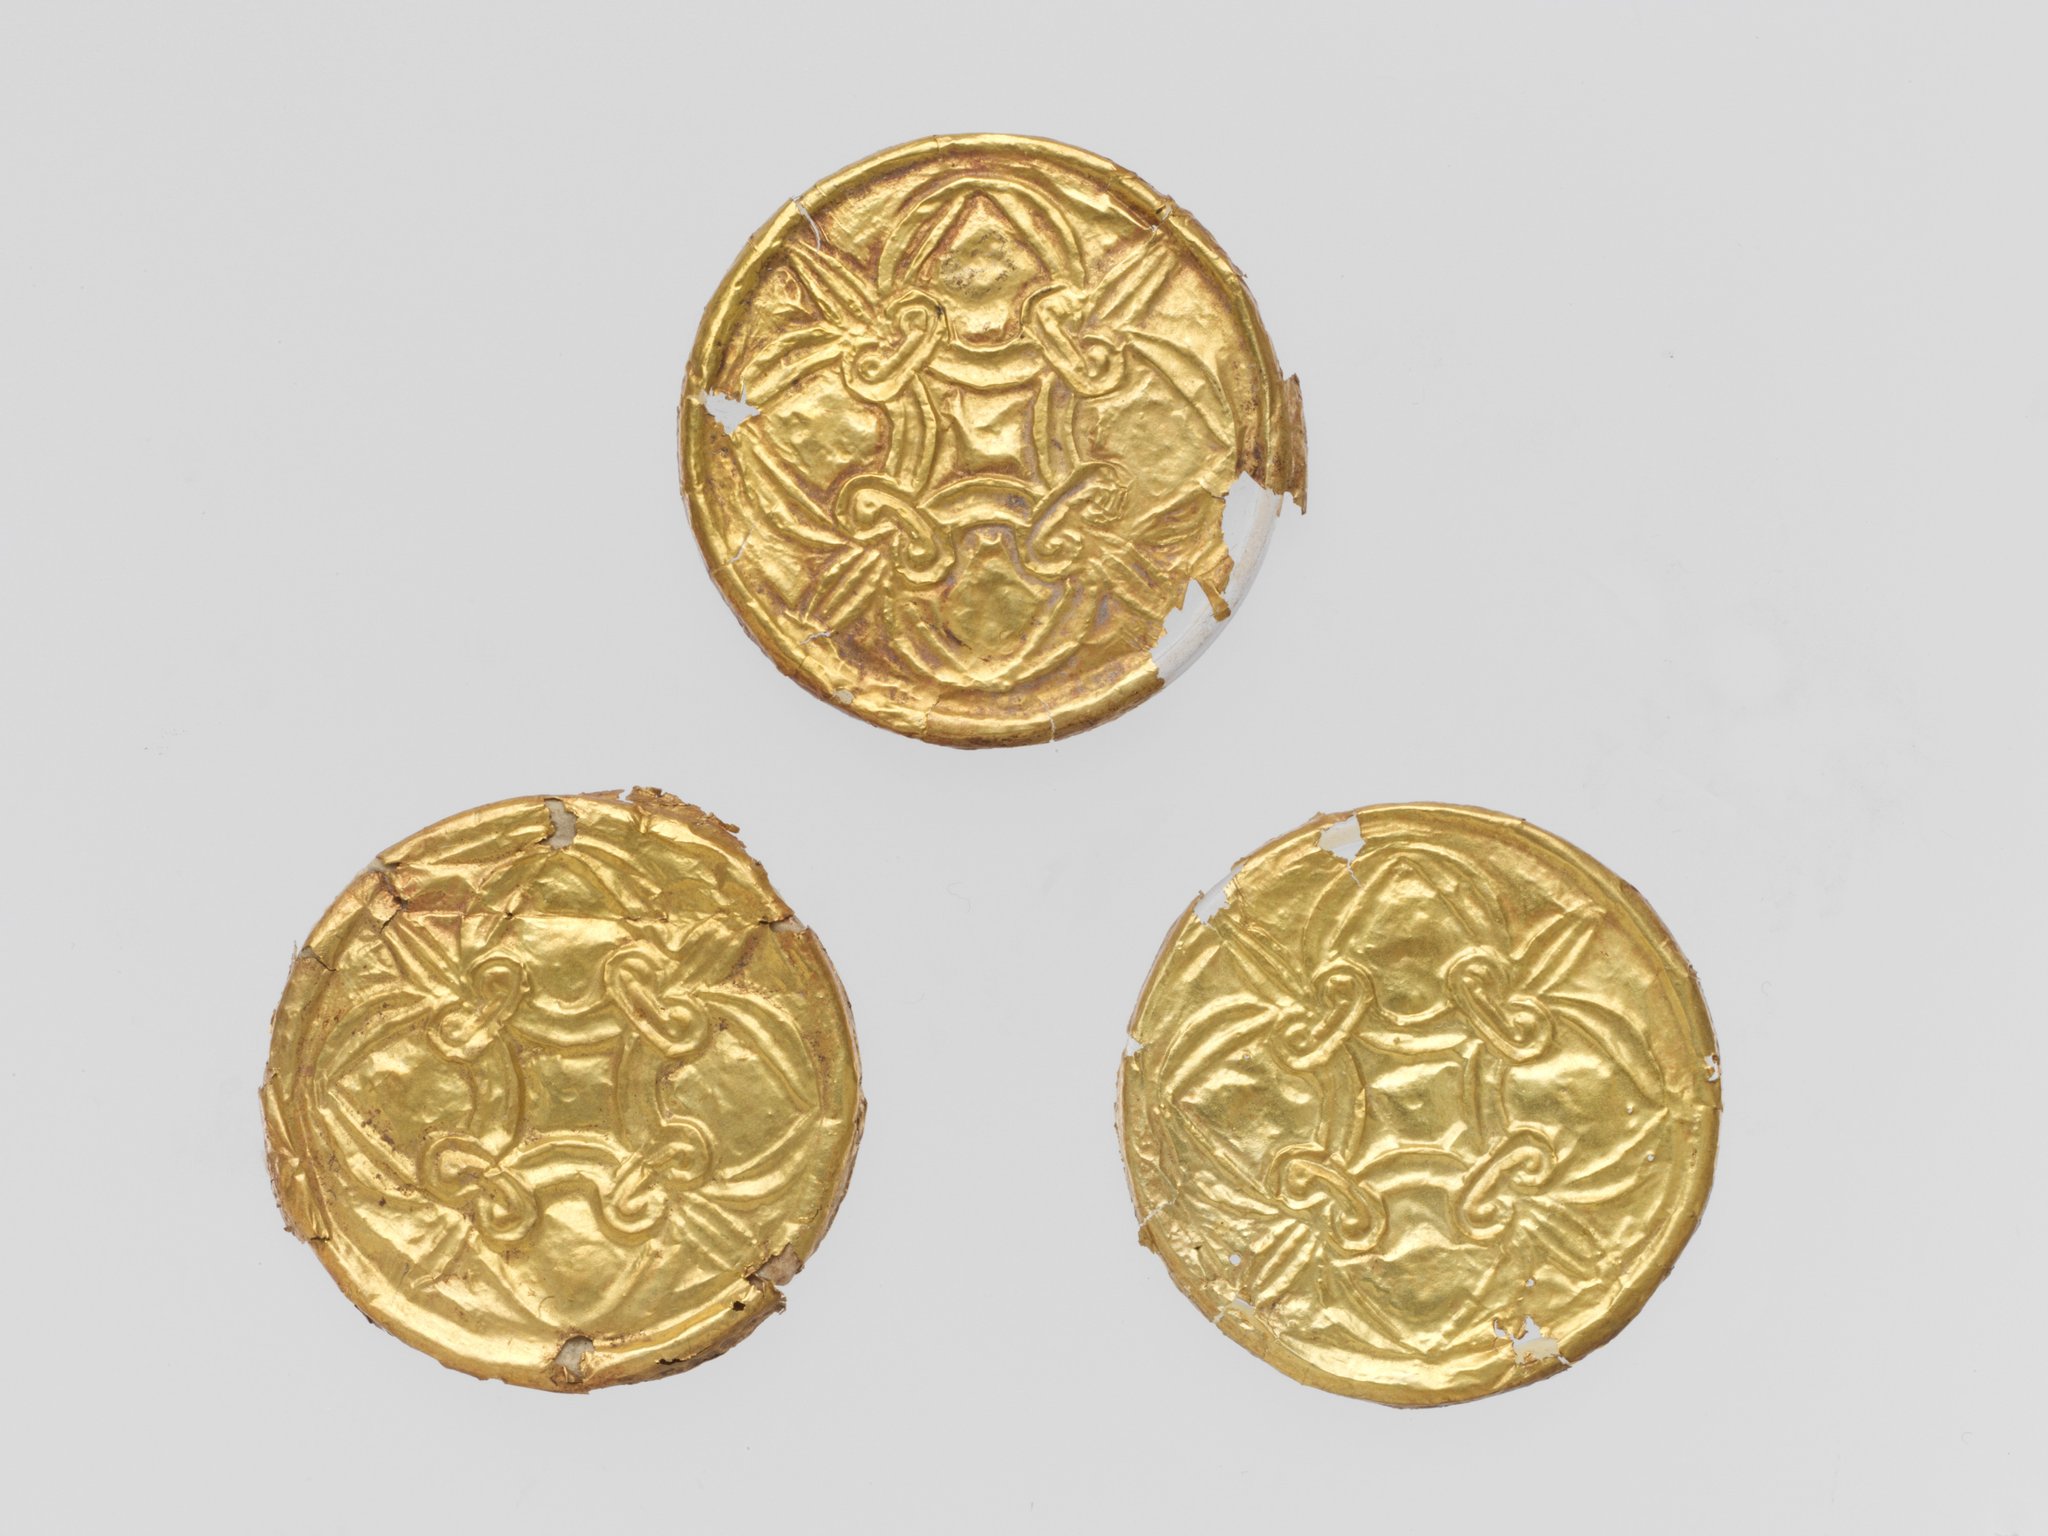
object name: roundel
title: Gold roundel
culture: cypriot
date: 1600-1050 BCE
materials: gold